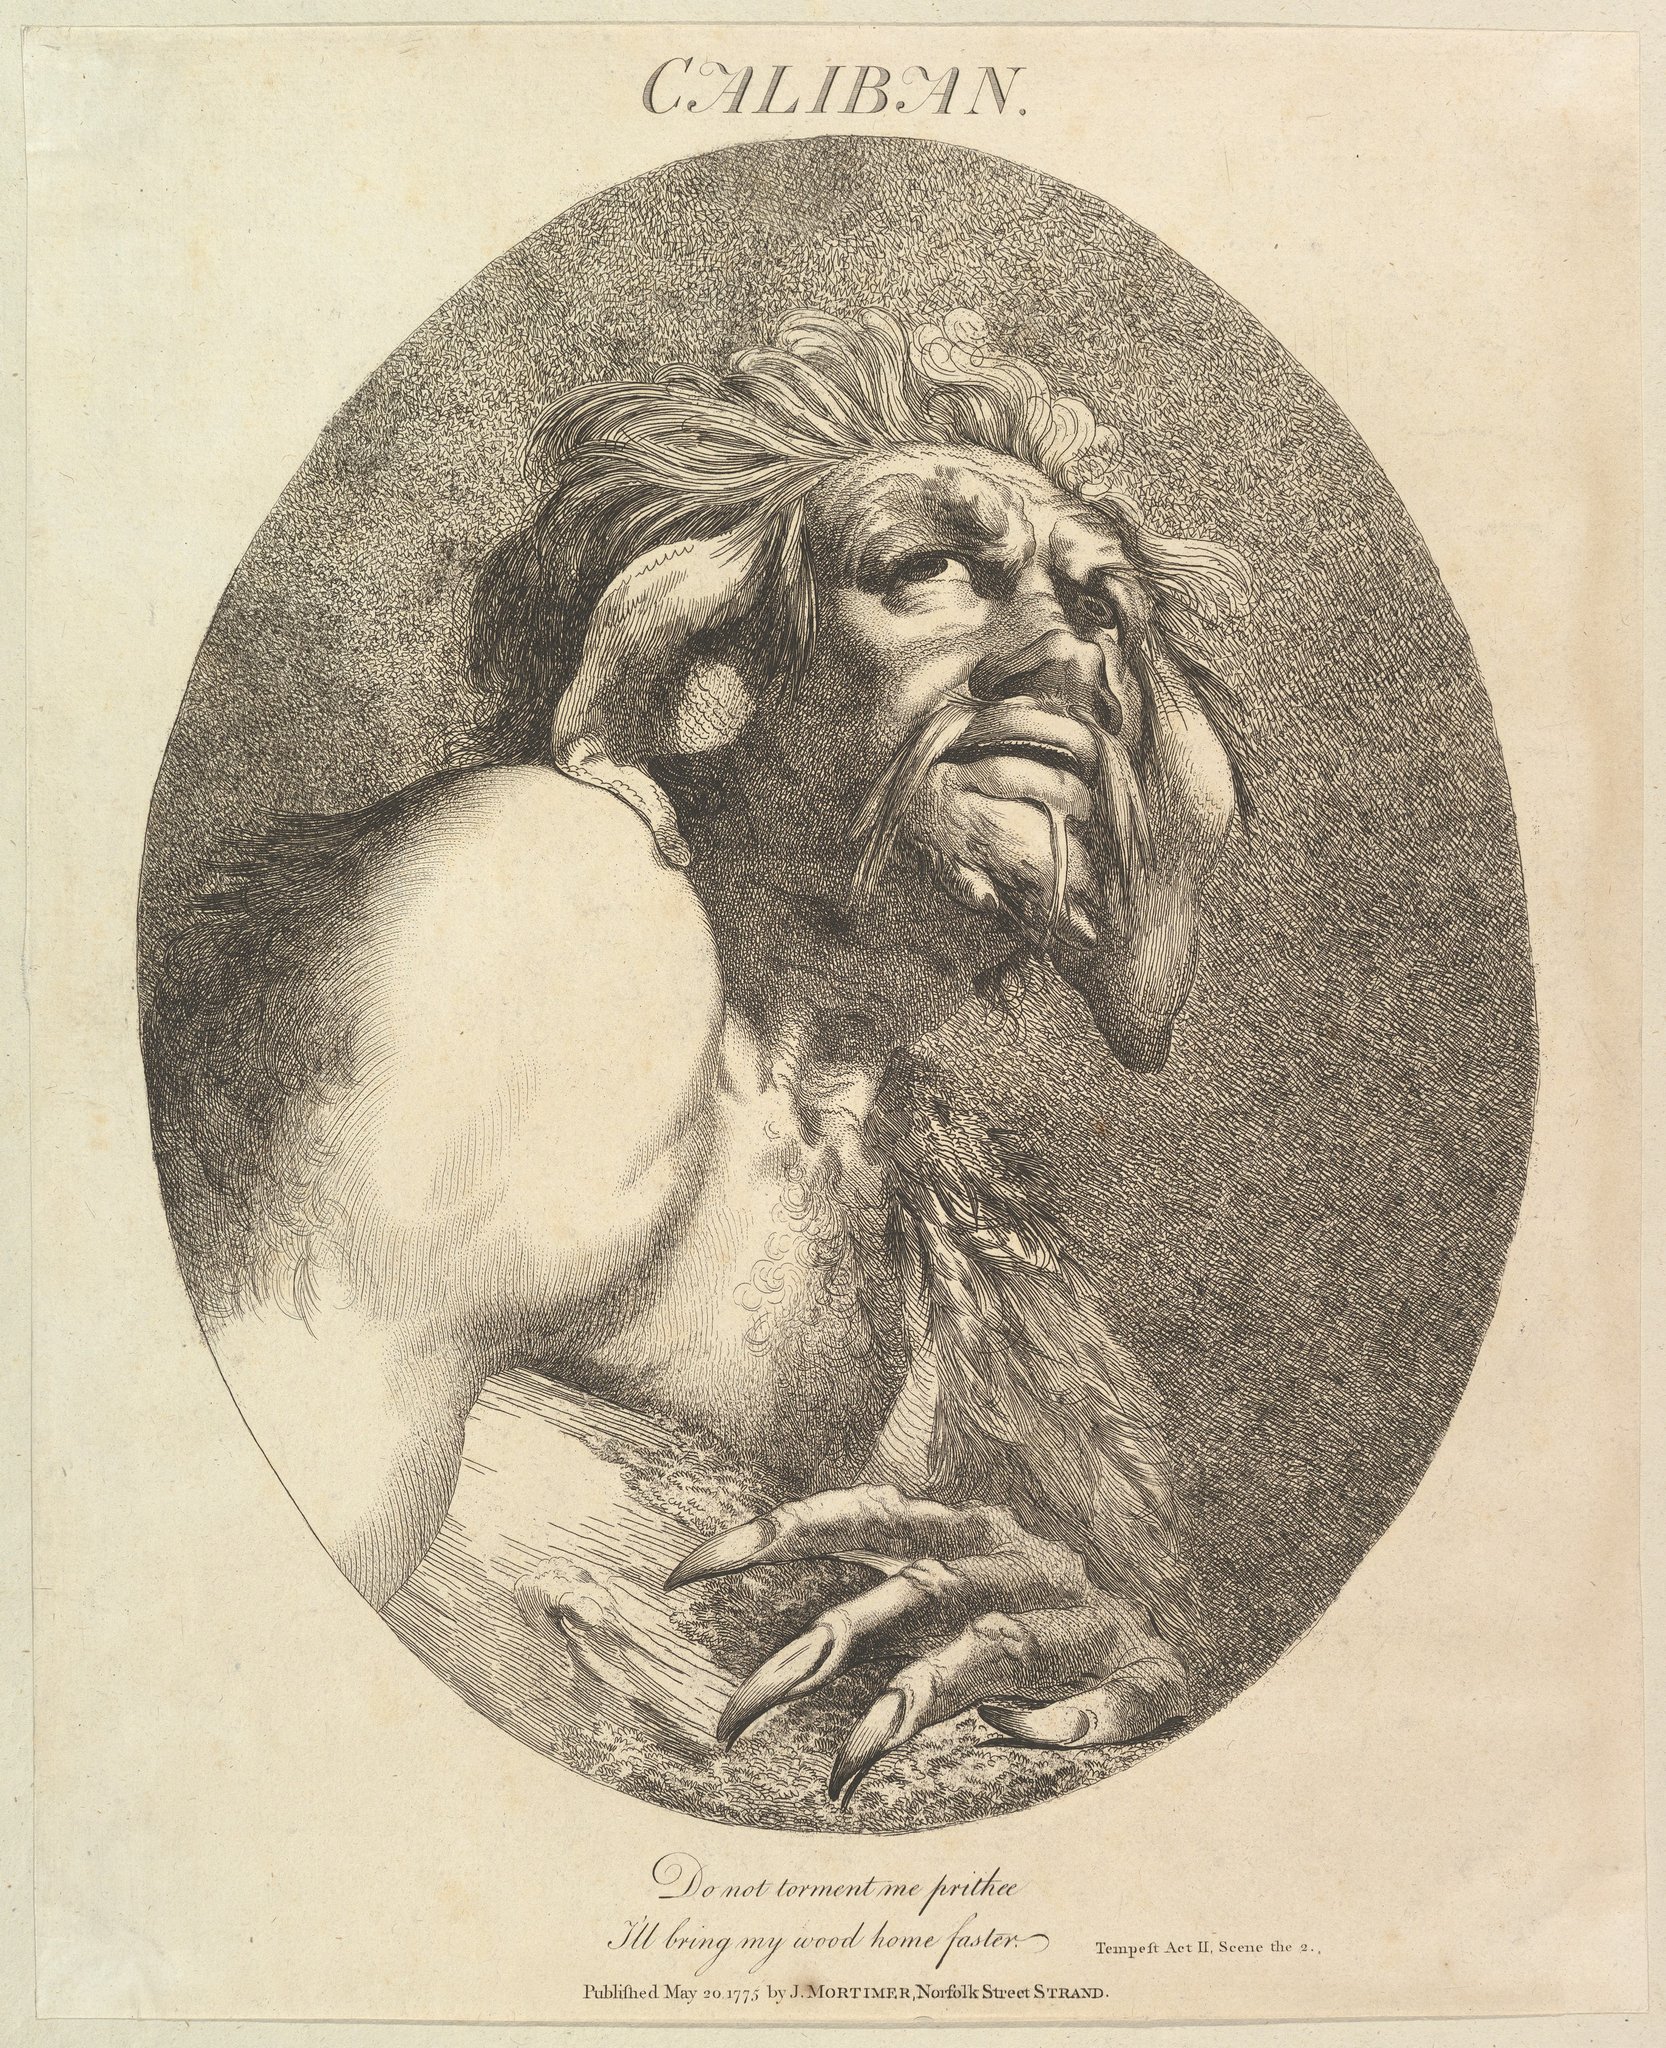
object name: print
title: Caliban, from "Twelve Characters from Shakespeare"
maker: john hamilton mortimer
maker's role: artist and publisher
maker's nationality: british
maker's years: 1740-1779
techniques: etching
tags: shakespeare,monsters